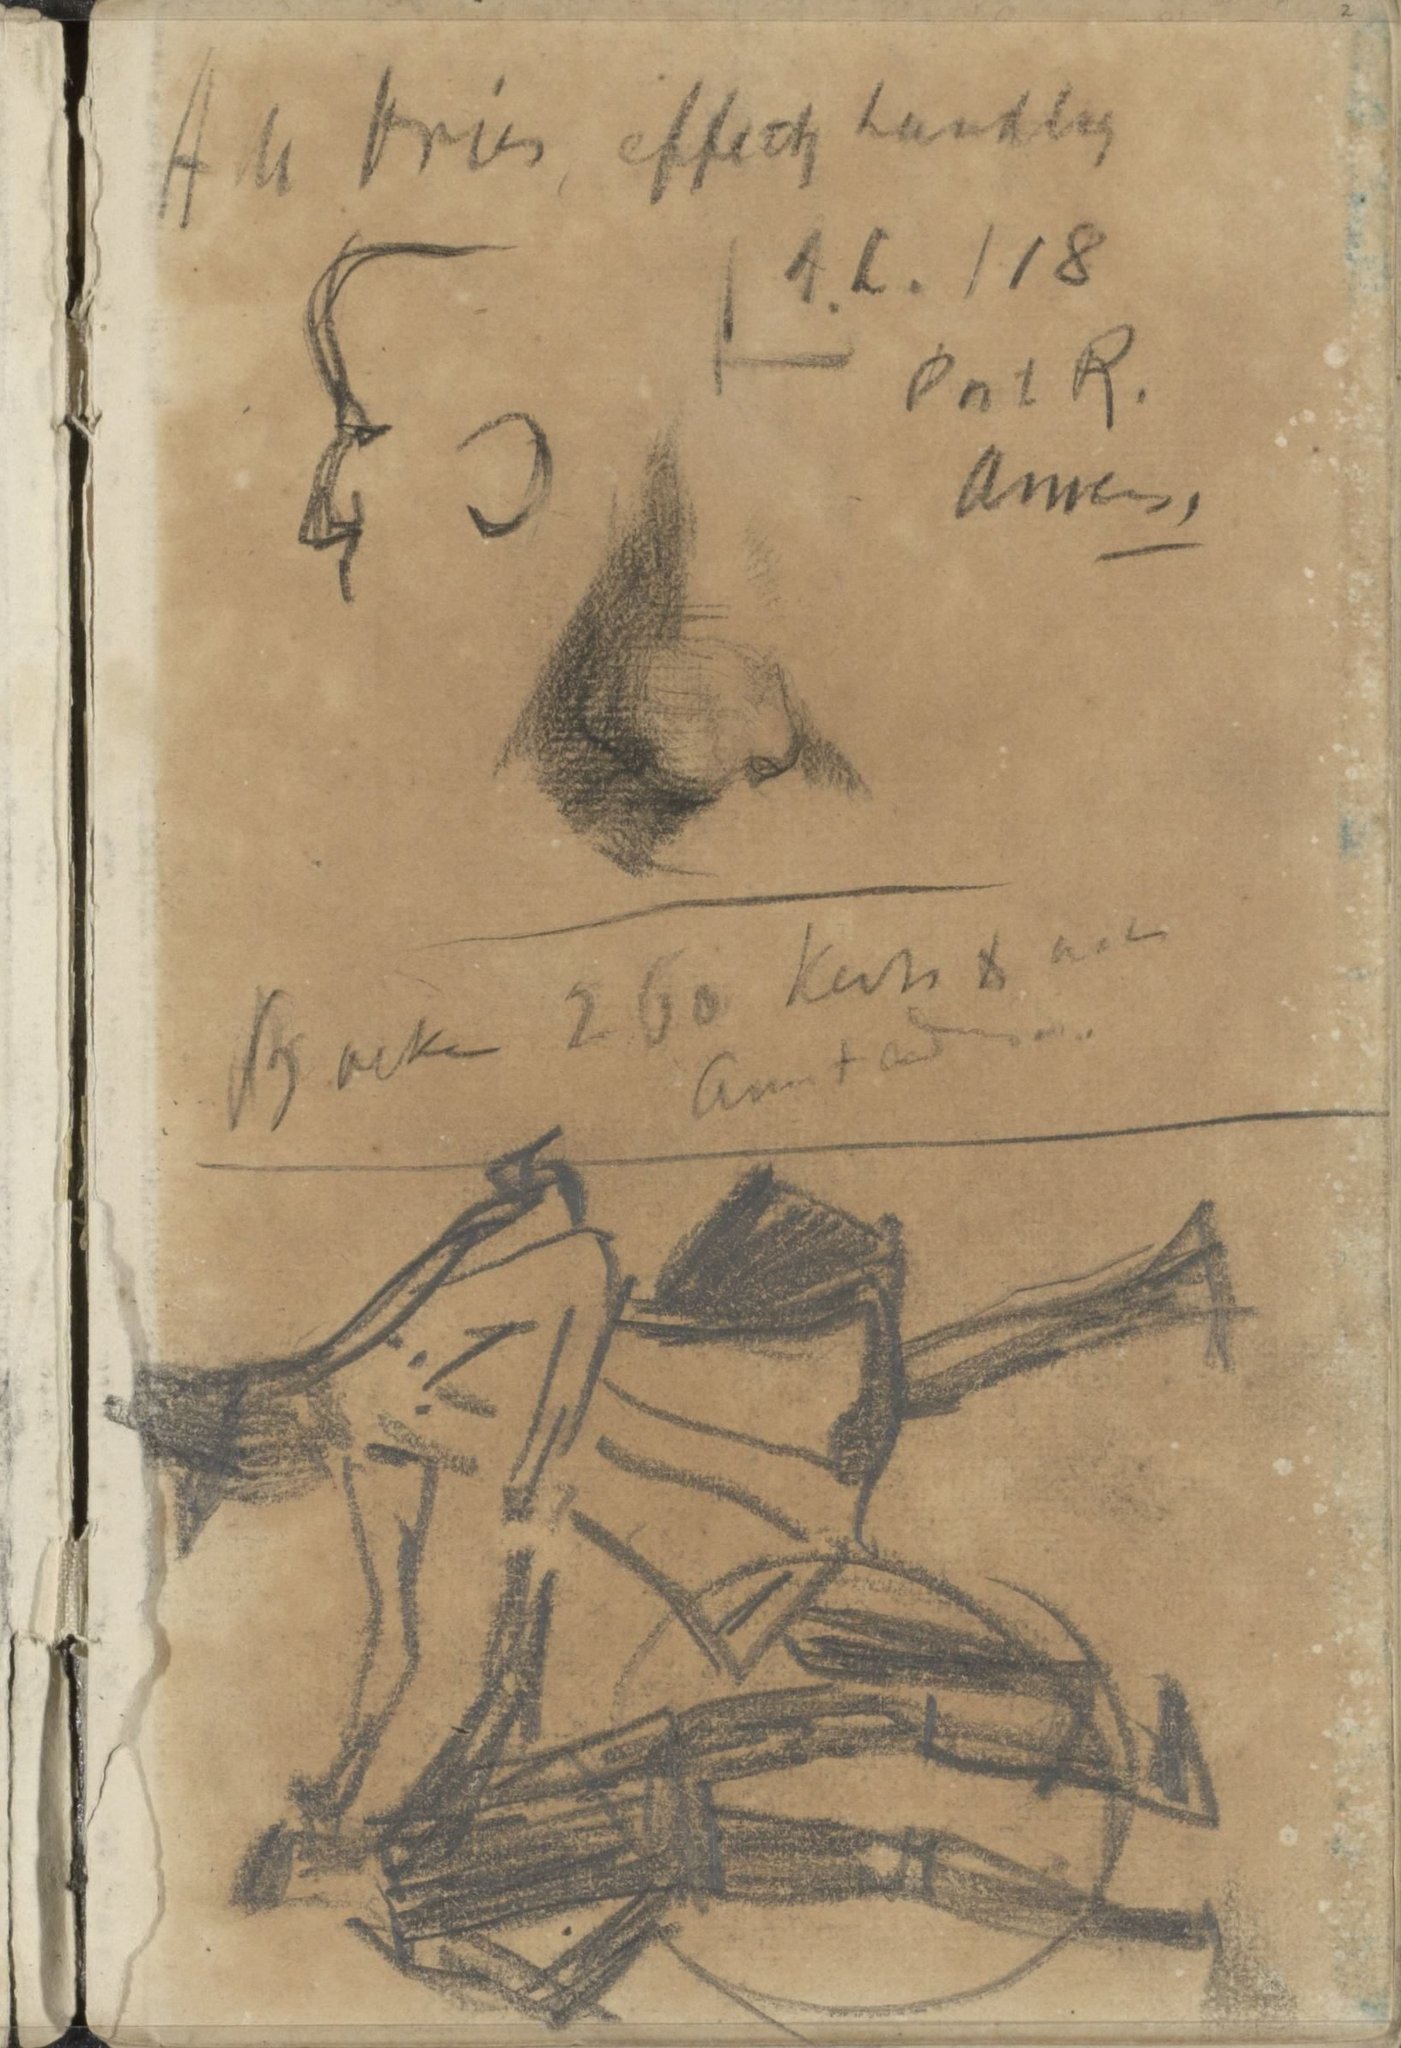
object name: sketchbook leaf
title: Studieblad met een gezicht, een neus en twee staande figuren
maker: george hendrik breitner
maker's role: draughtsman, painter, print maker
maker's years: 1857-1923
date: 1887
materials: chalk, paper, pencil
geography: amsterdam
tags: face, standing figure, parts of the face: nose, standing figure - aa - female human figure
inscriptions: annotation: ‘A. de Vries [...]’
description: Pagina 2 uit een schetsboek met 12 bladen.